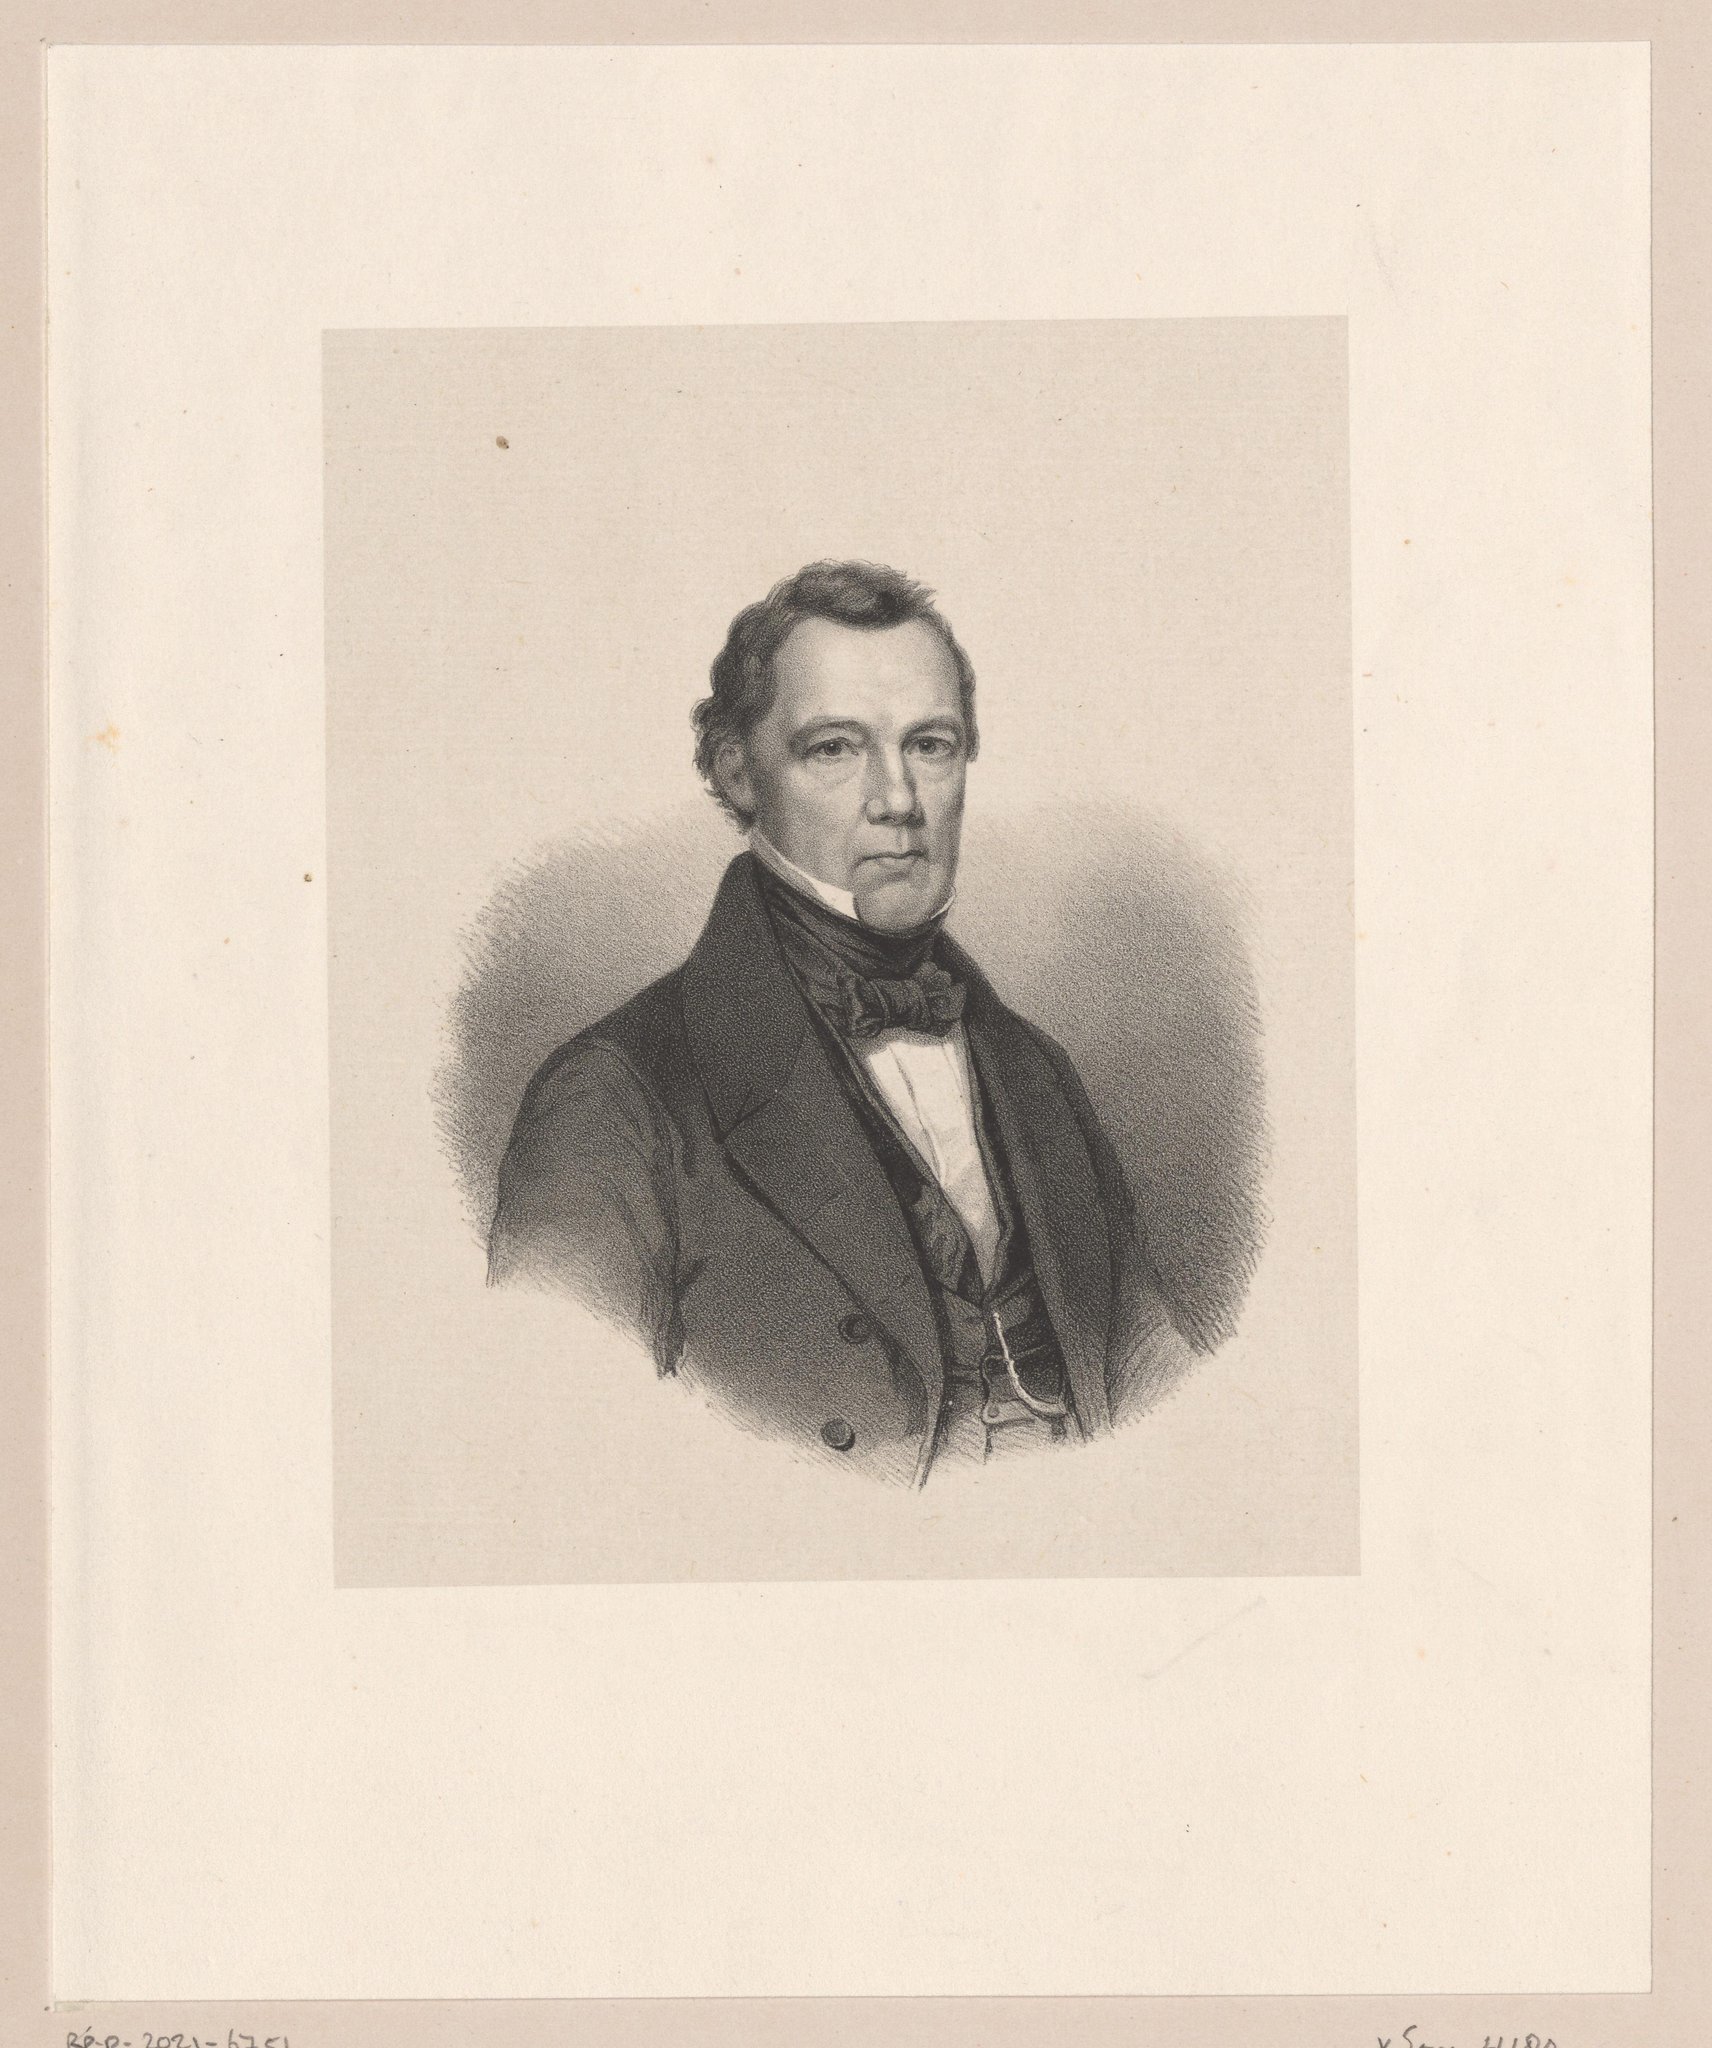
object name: print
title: Portret van een onbekende man, mogelijk Barend Peelen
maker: Anonymous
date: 1820-1899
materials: paper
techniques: lithograph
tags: adult man, historical persons